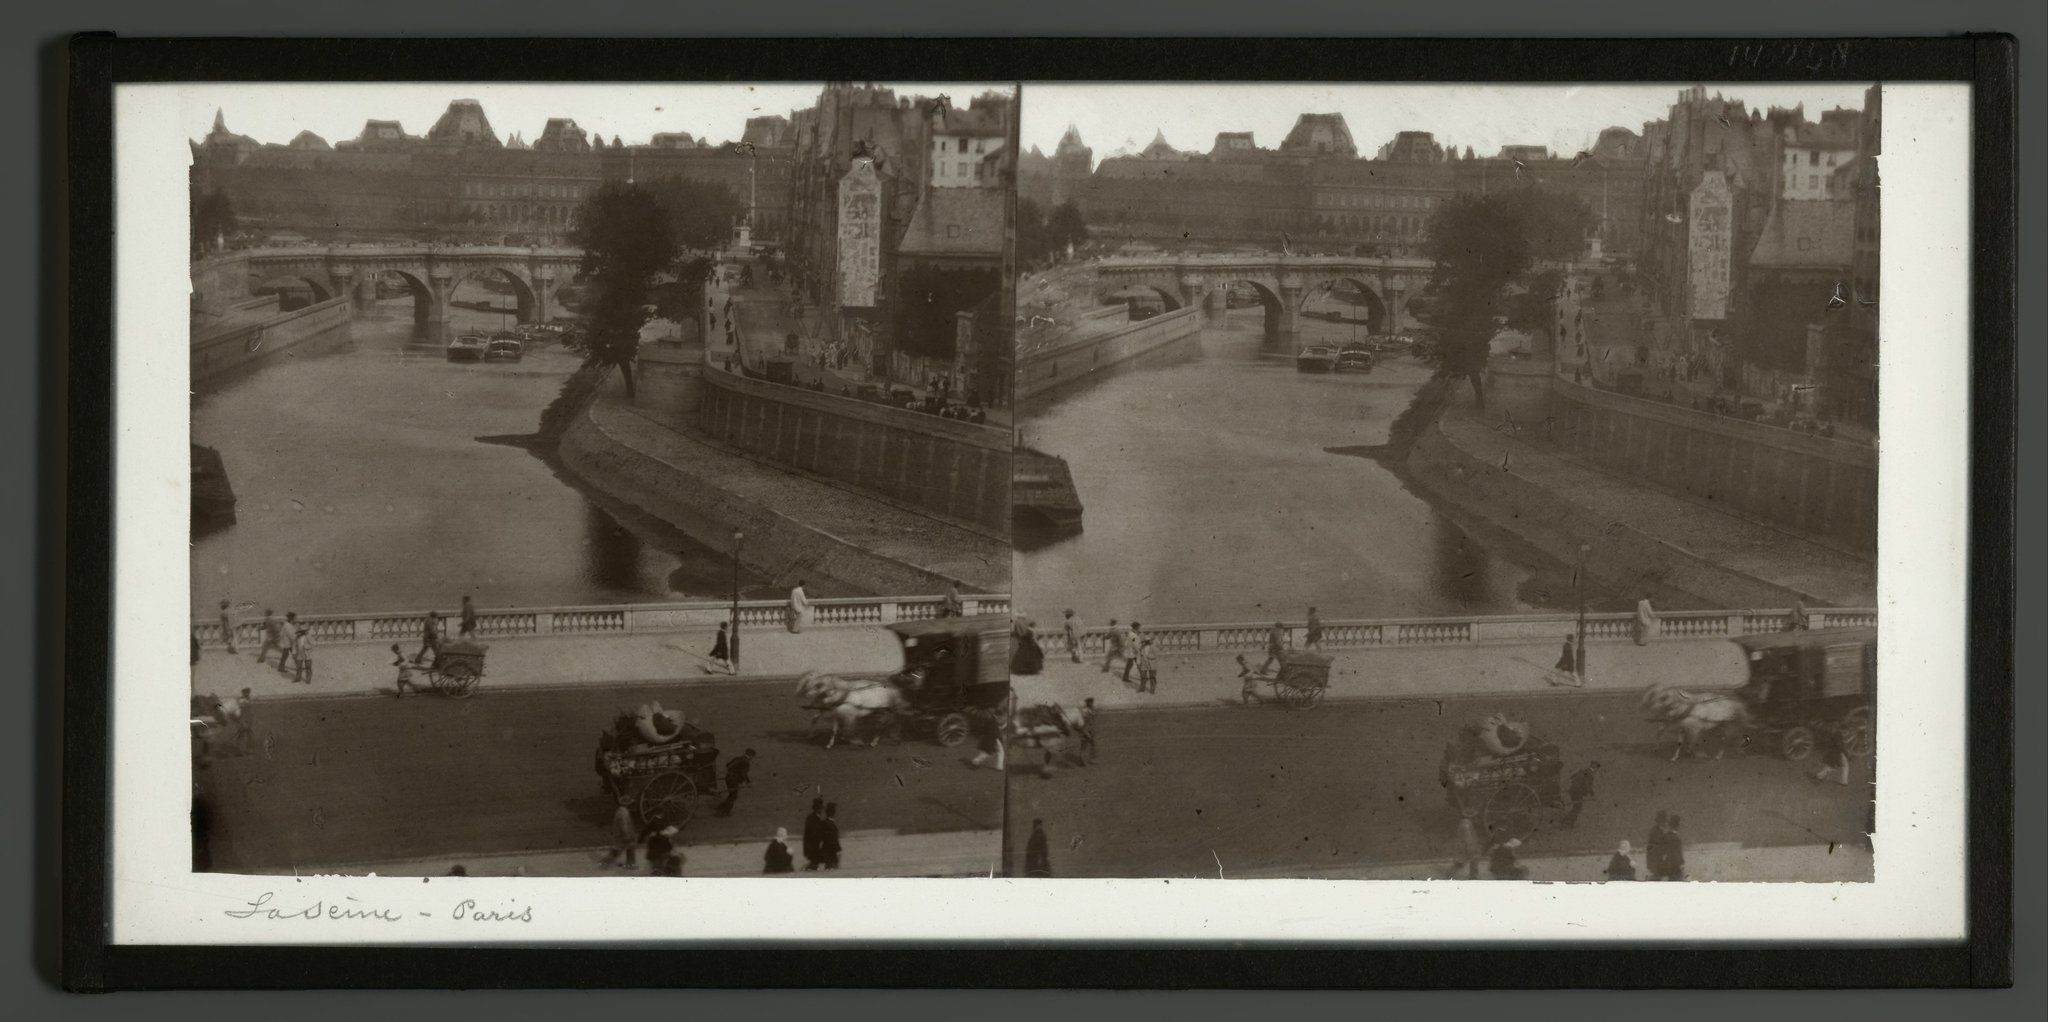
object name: stereoscopic photograph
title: Gezicht op de Seine in Parijs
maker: Anonymous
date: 1855-1880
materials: glass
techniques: slide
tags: bridge in city across river, canal, etc., paris